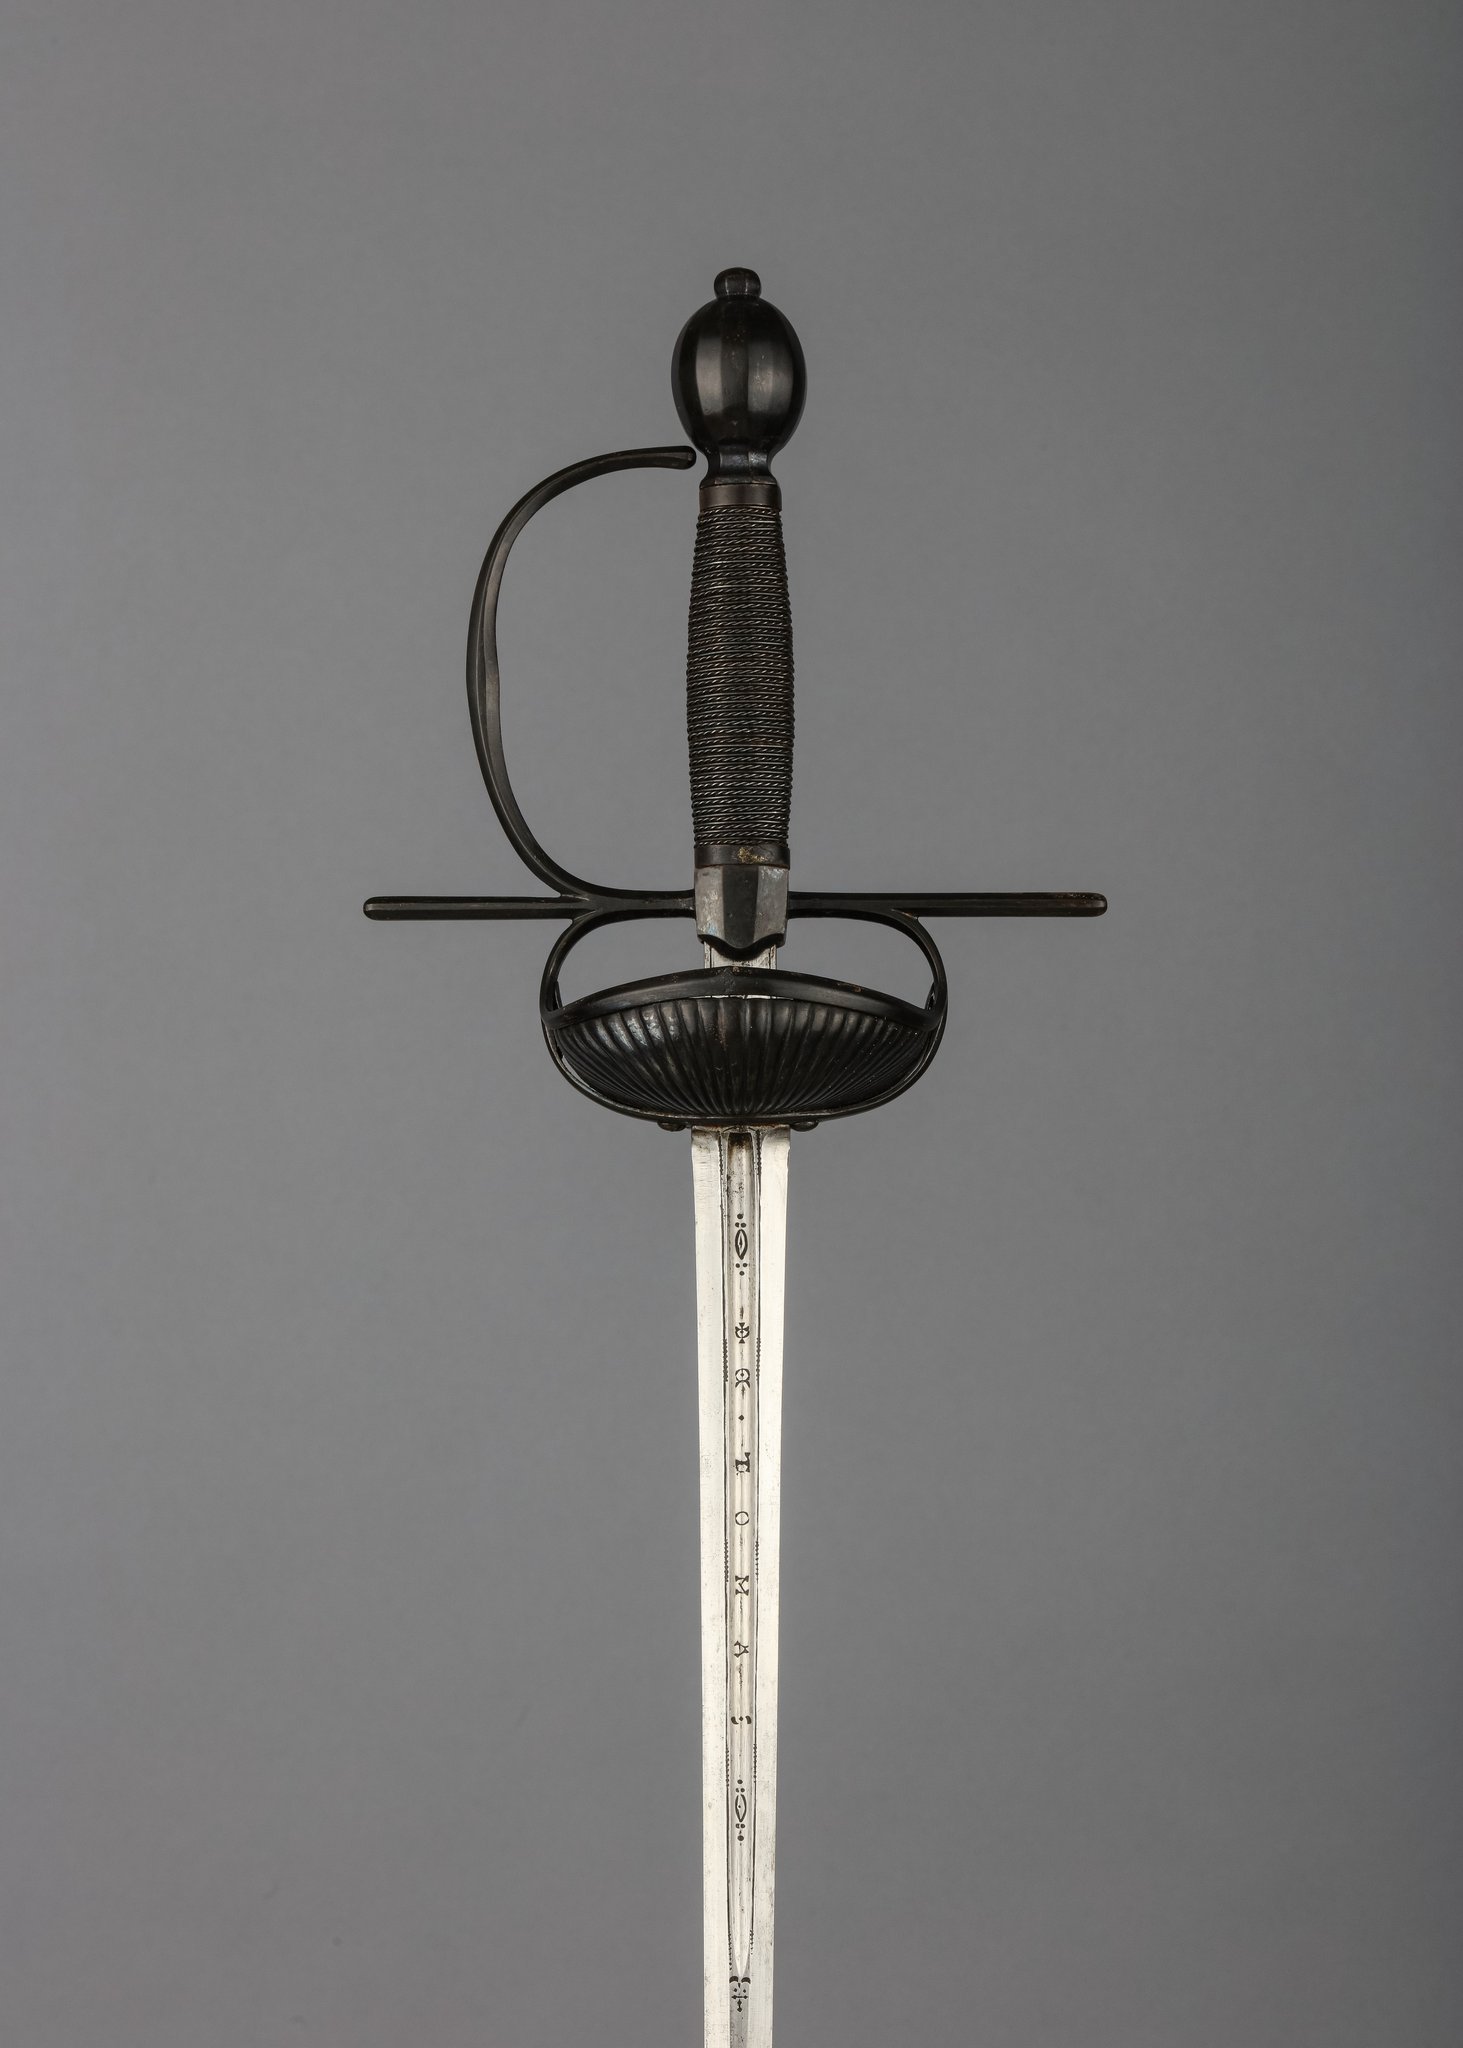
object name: rapier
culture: blade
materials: steel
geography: spain